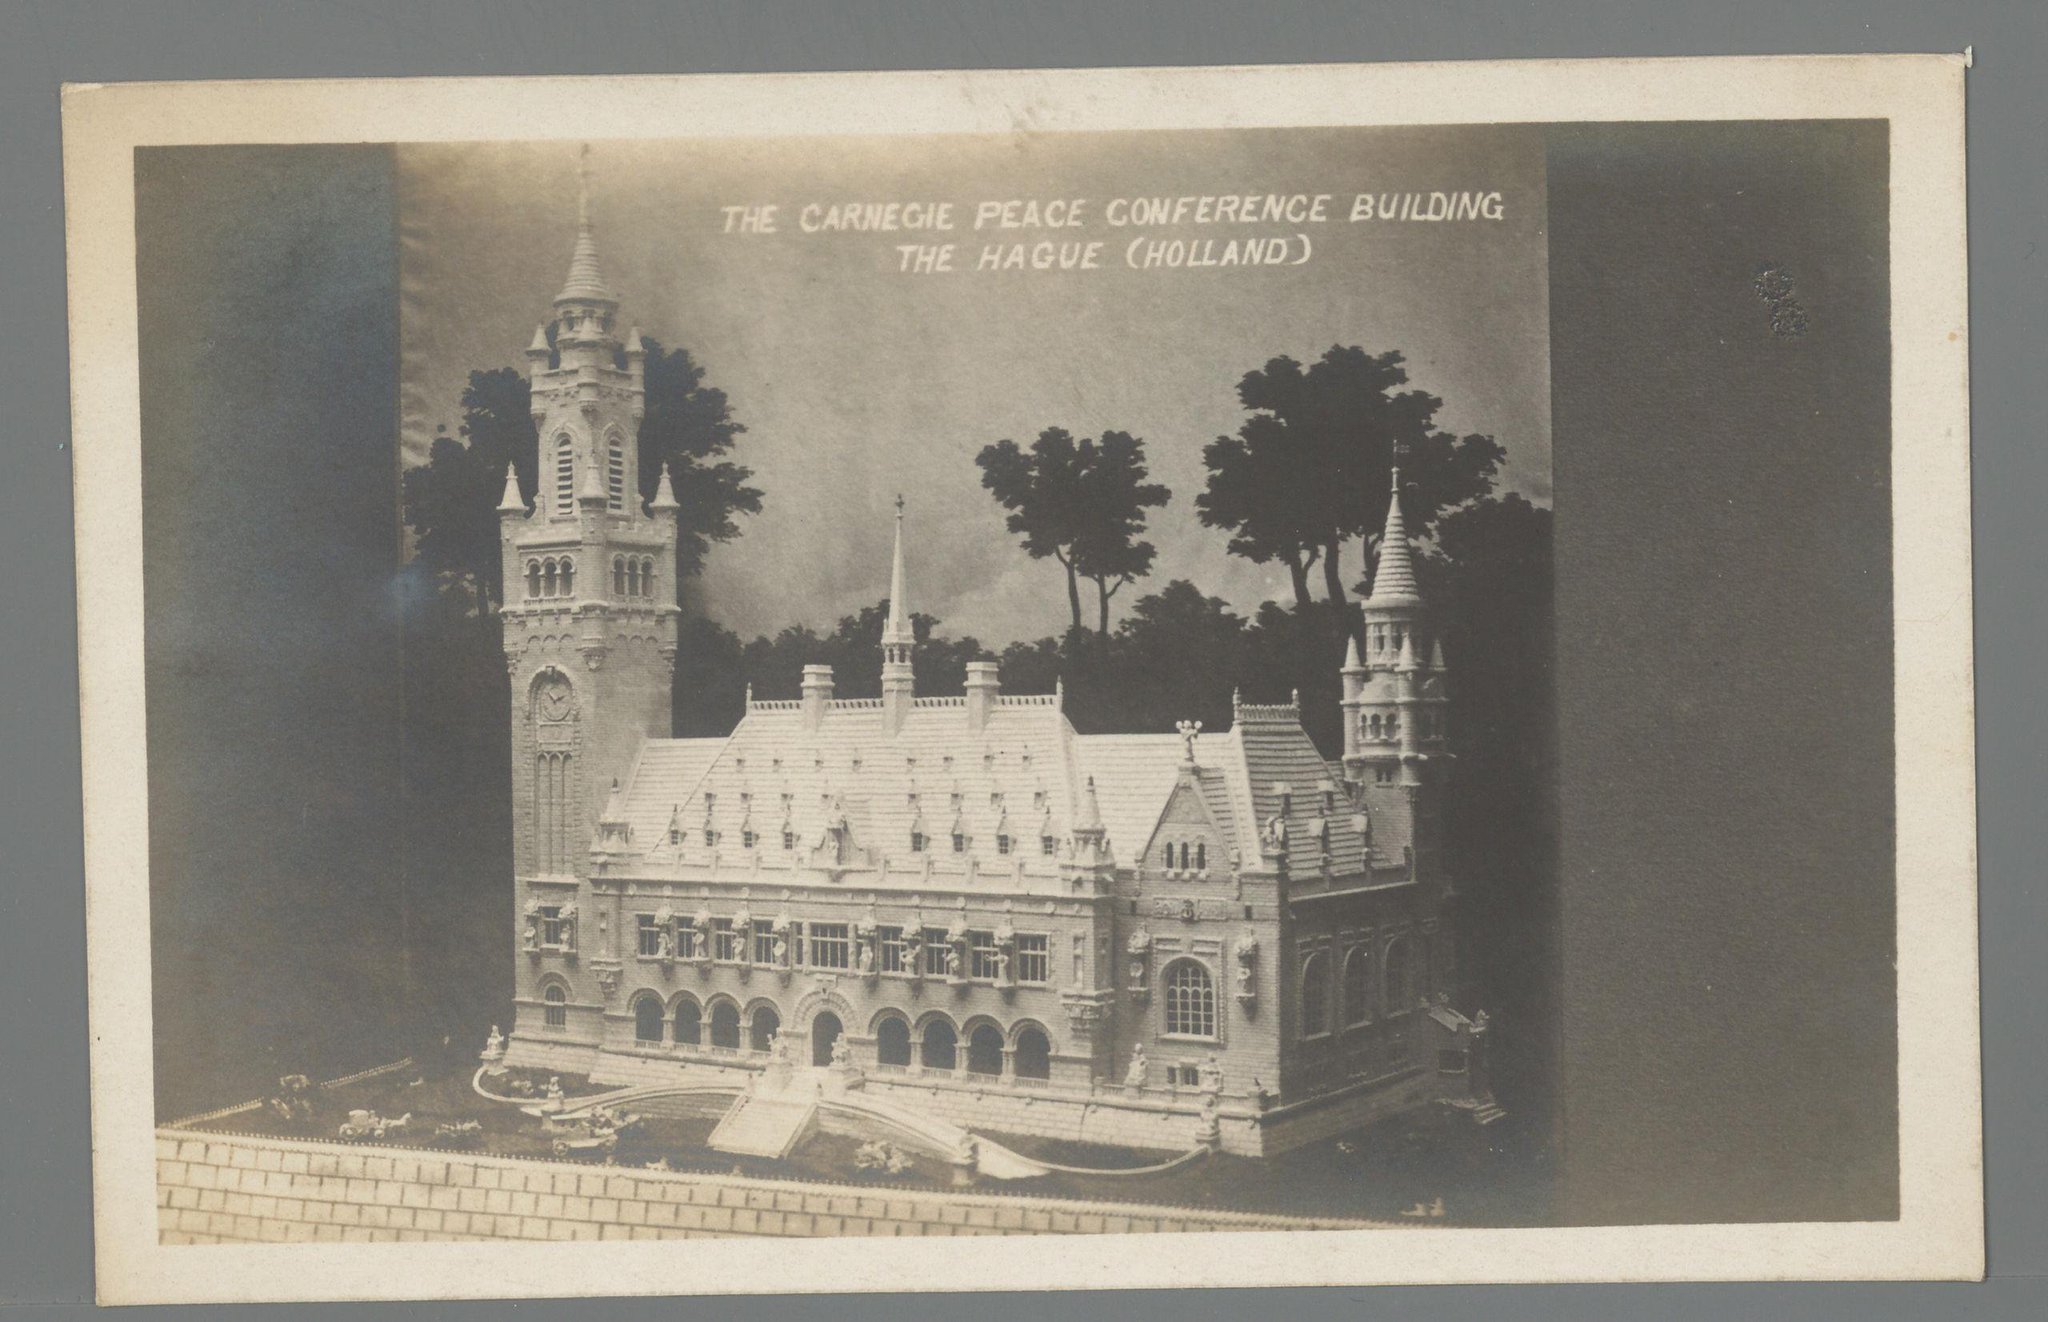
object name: ansichtkaart, prentbriefkaart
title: The Carnegie Peace Conference Building. The Hague (Holland)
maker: Anonymous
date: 1906-1930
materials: photographic support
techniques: gelatin silver print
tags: palace, model ~ architecture